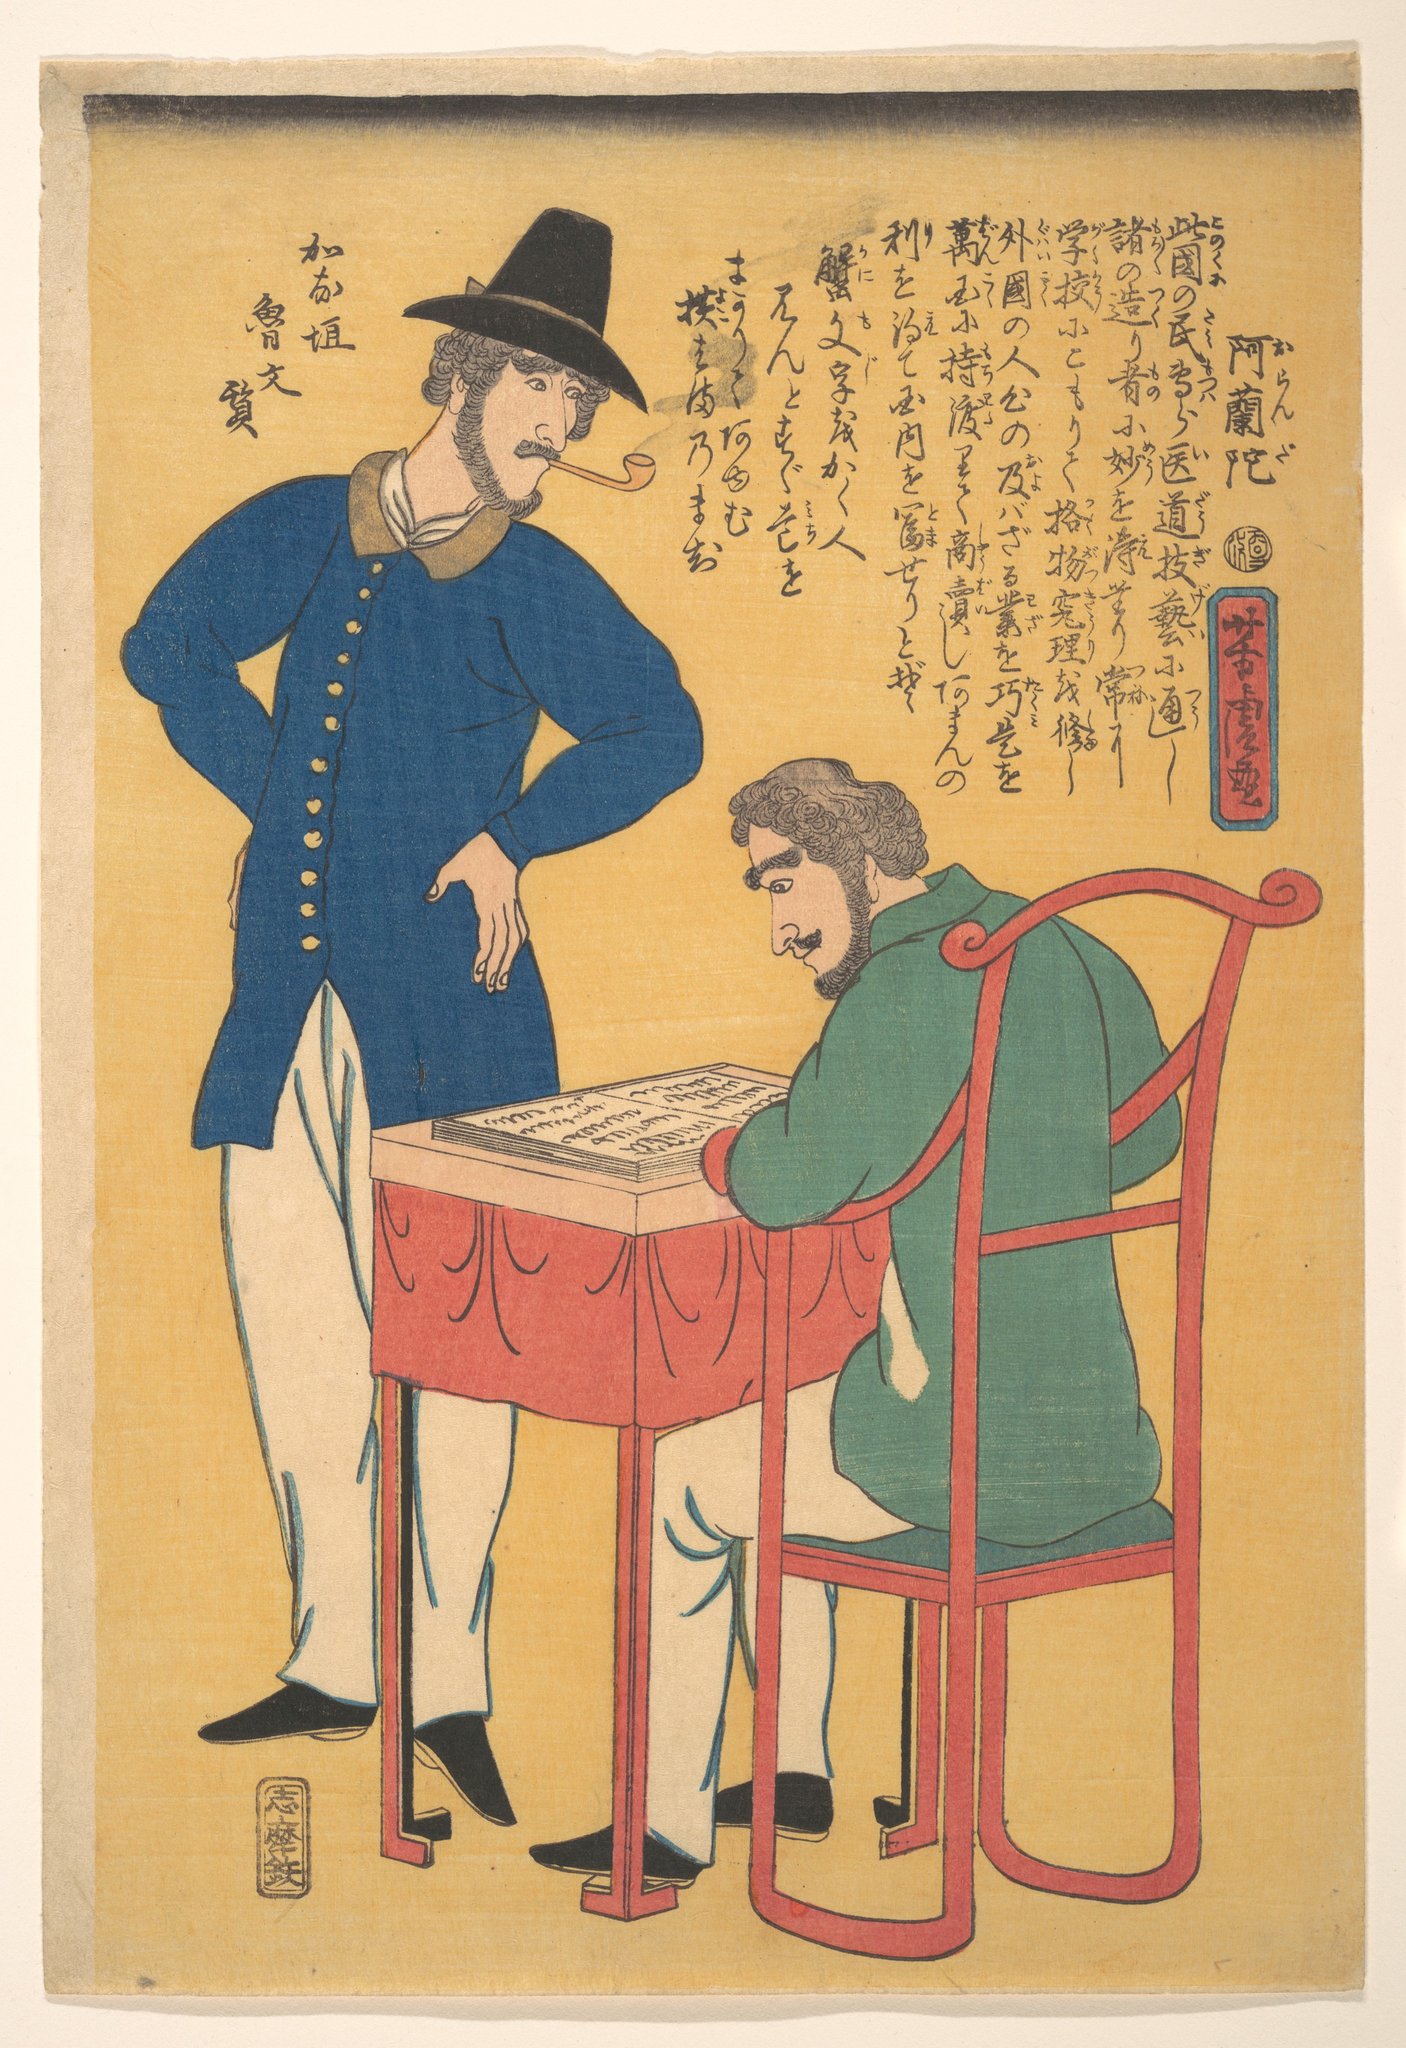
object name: print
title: Dutch Printers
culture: japanese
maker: utagawa yoshitora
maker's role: artist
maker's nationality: japanese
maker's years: 1845-1880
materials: ink, paper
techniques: woodblock print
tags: men,reading,smoking